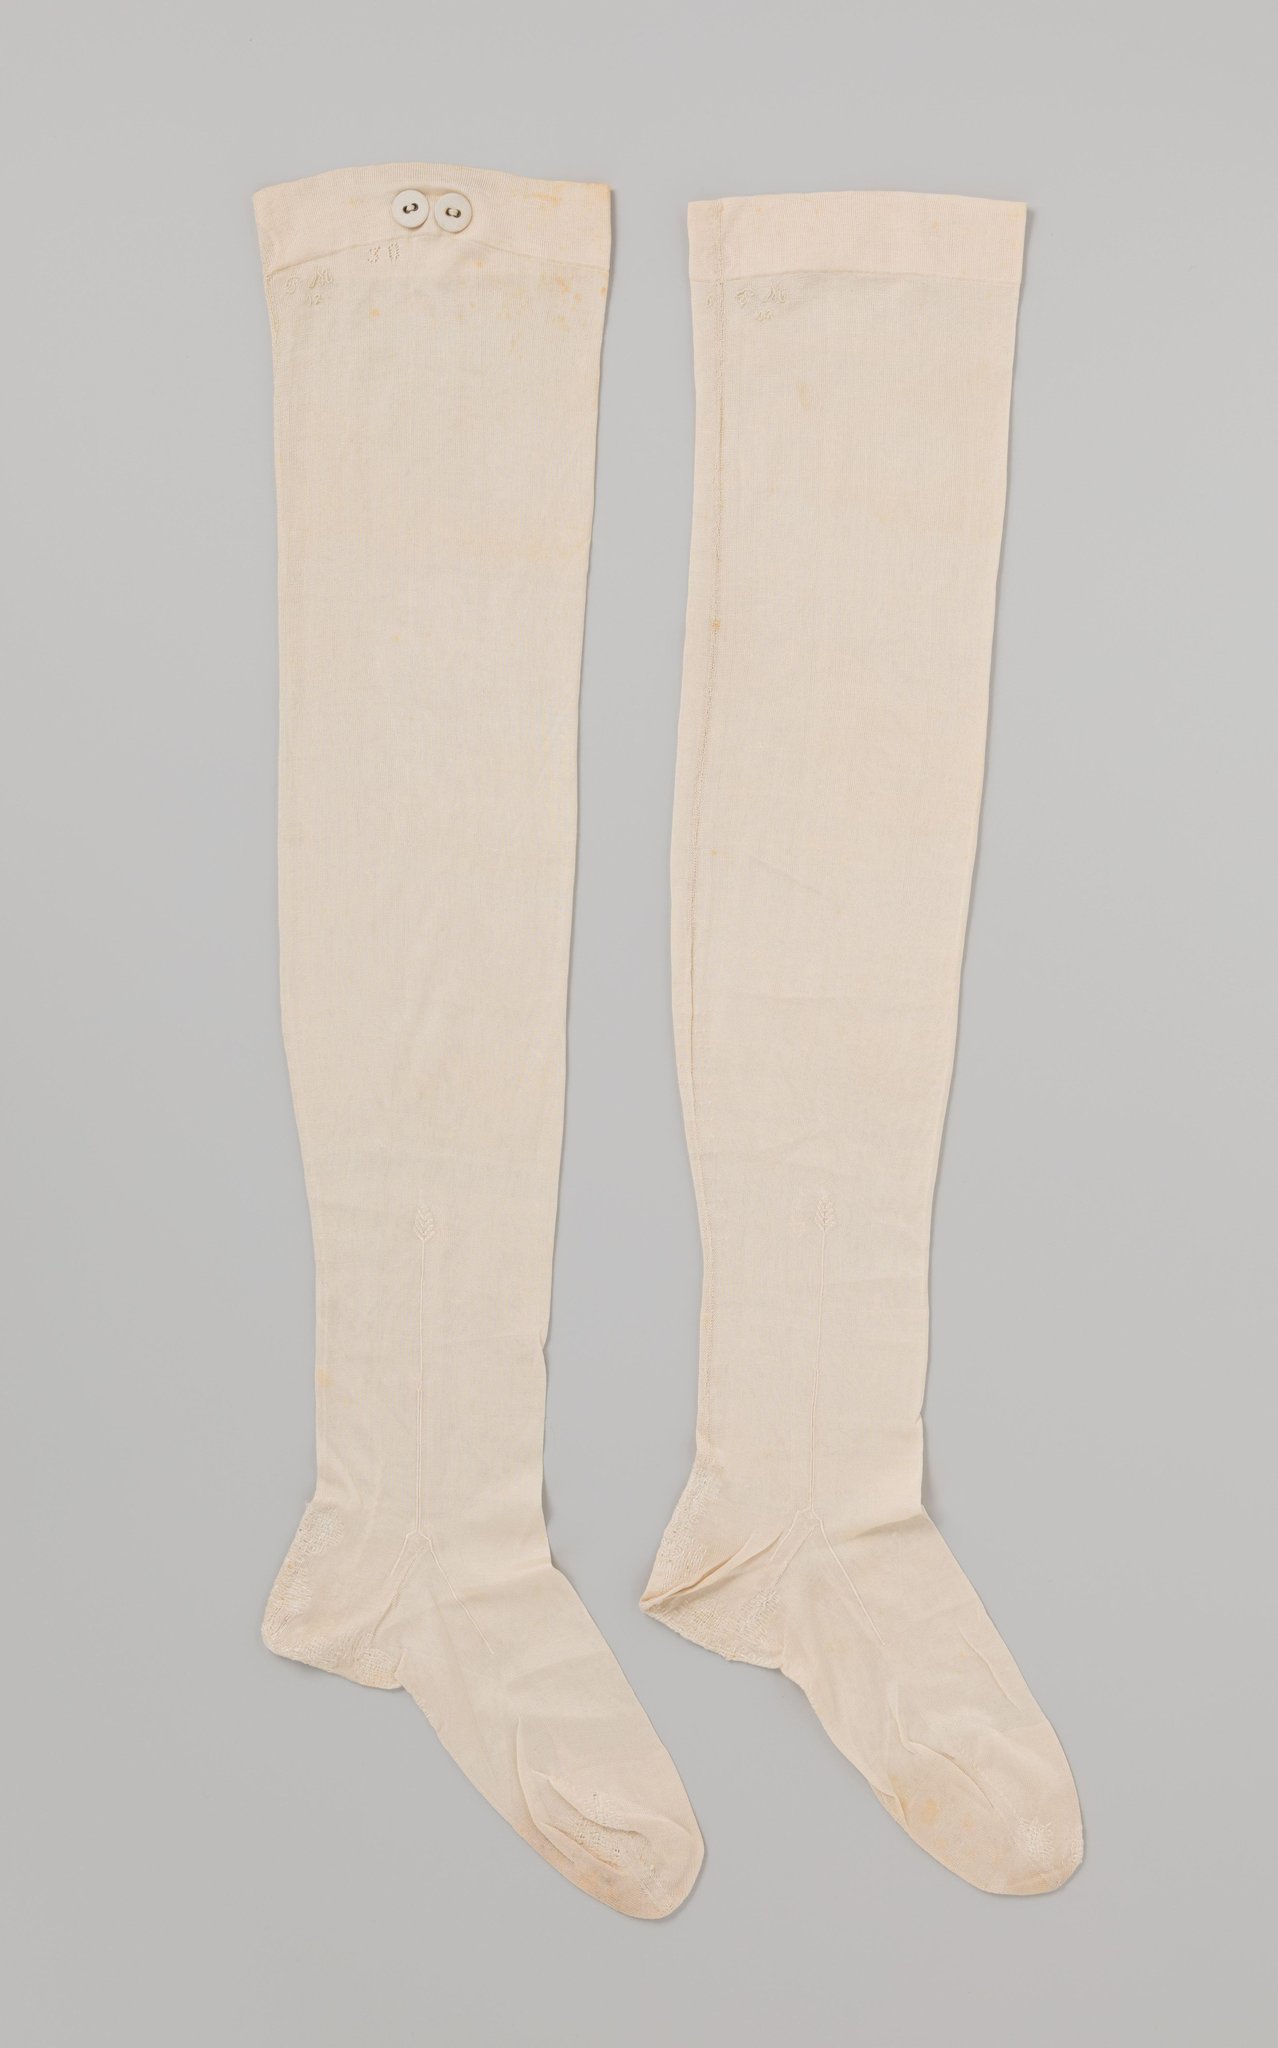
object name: clothing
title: Kous van effen crèmekleurige zijde, met een verticale streep uitlopend in een palmvorm op de klink, aan de boord twee knopen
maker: Anonymous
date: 1900-1910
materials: silk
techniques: embroidered, knitting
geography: paris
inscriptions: size: ‘6’, initials: ‘PM 12’, address: ‘PARIS’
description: Kous van effen crèmekleurige zijde, met een verticale streep uitlopend in een palmvorm op de klink, aan de boord twee stoffen knopen. Opschrift: 'PM', '12', '6' en 'PARIS'.